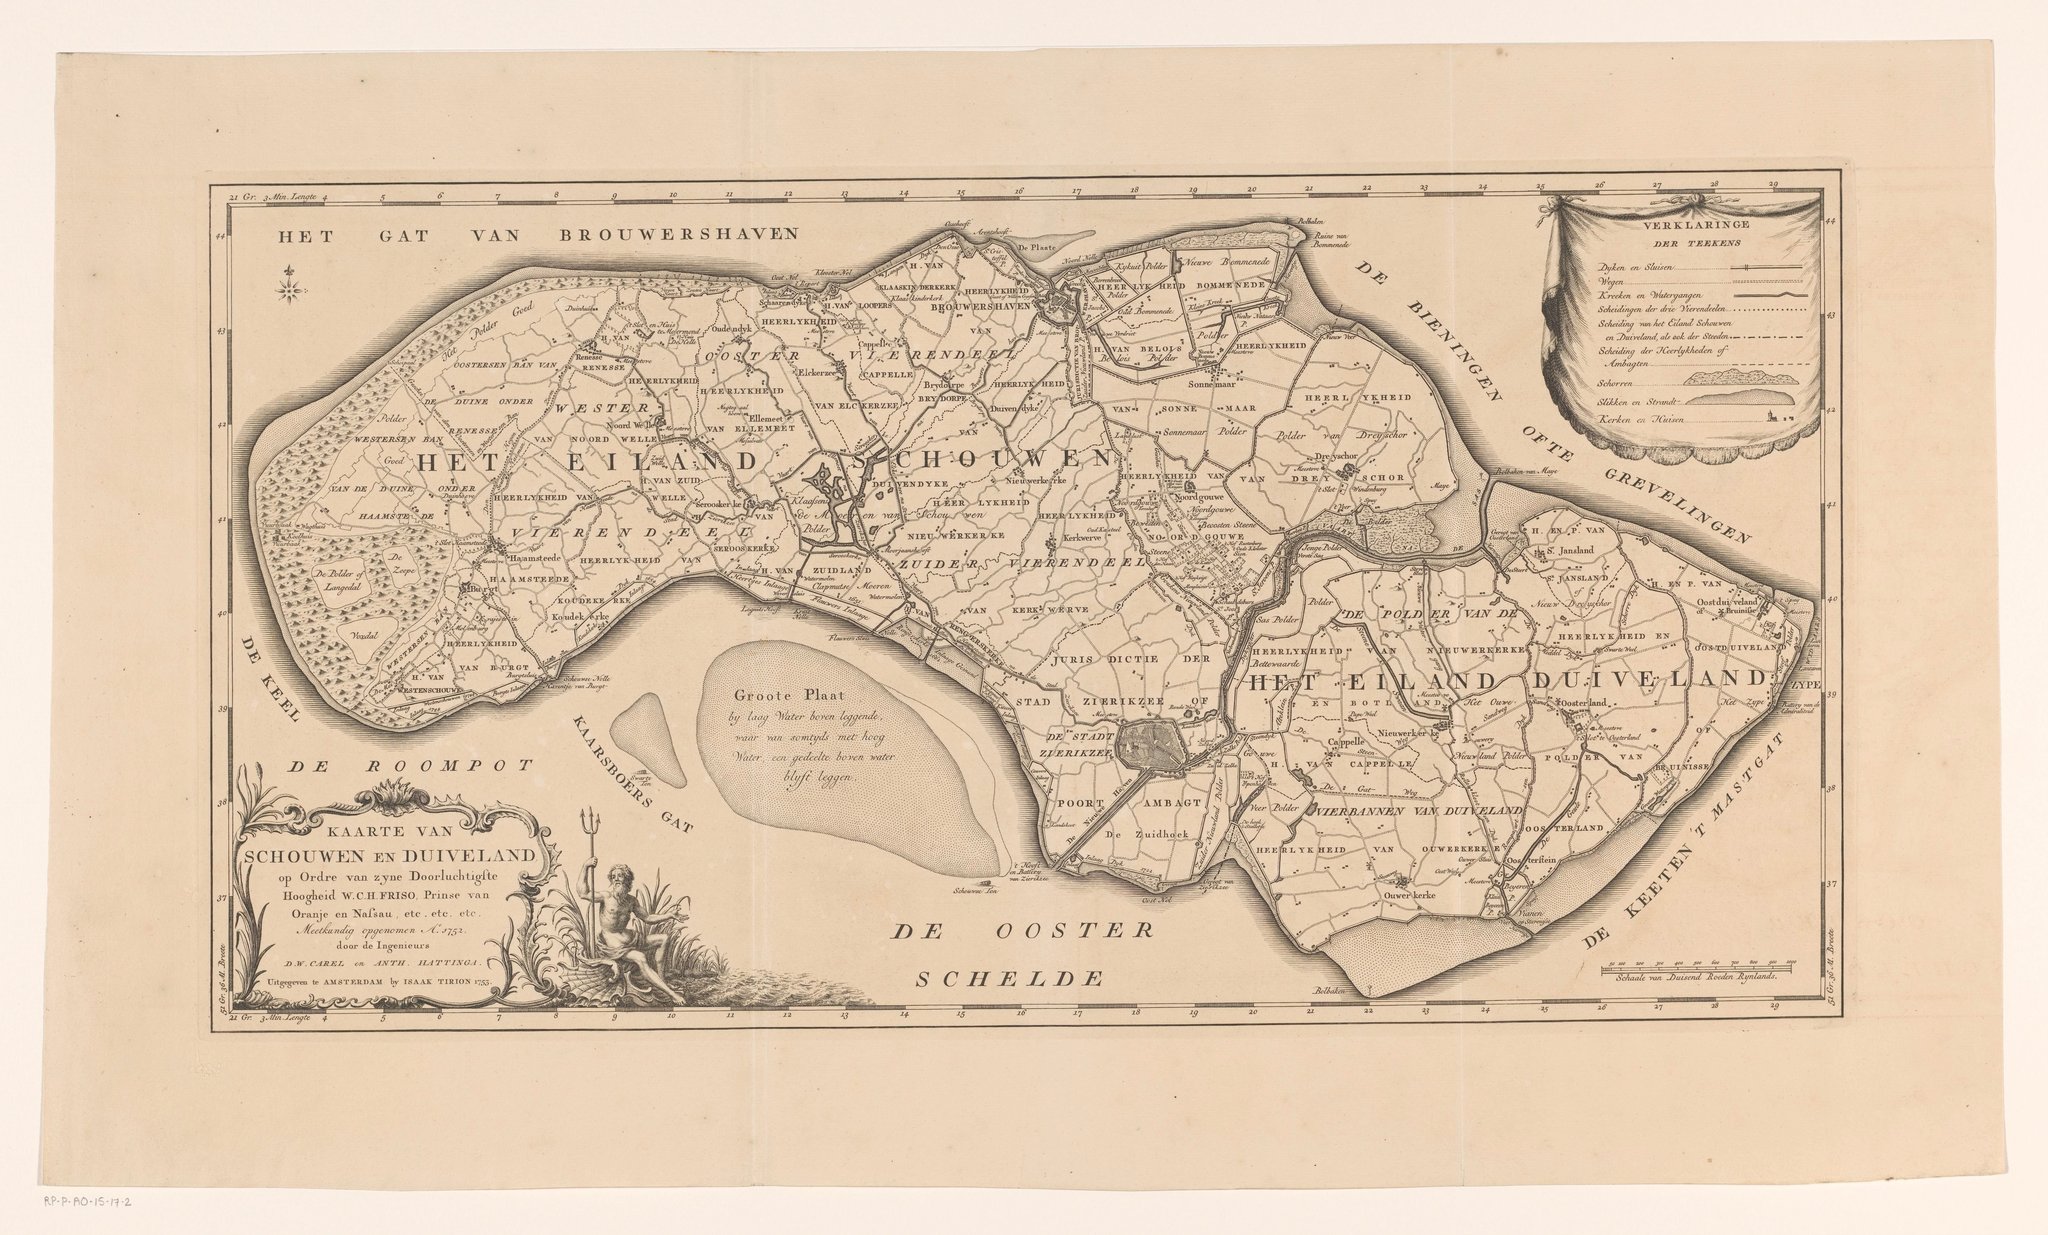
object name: print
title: Kaarte van Schouwen en Duiveland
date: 1753-1760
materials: paper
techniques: engraving, etching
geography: amsterdam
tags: (story of) neptune (poseidon), maps of separate countries or regions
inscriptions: collector's mark: Lugt 195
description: Linksonder de titelcartouche met rechts Neptunus. Rechtsboven een cartouche met de legenda. Rechtsonder een schaalstok: Schaale van duisend roeden Rynlands. Gradenverdeling langs de randen.